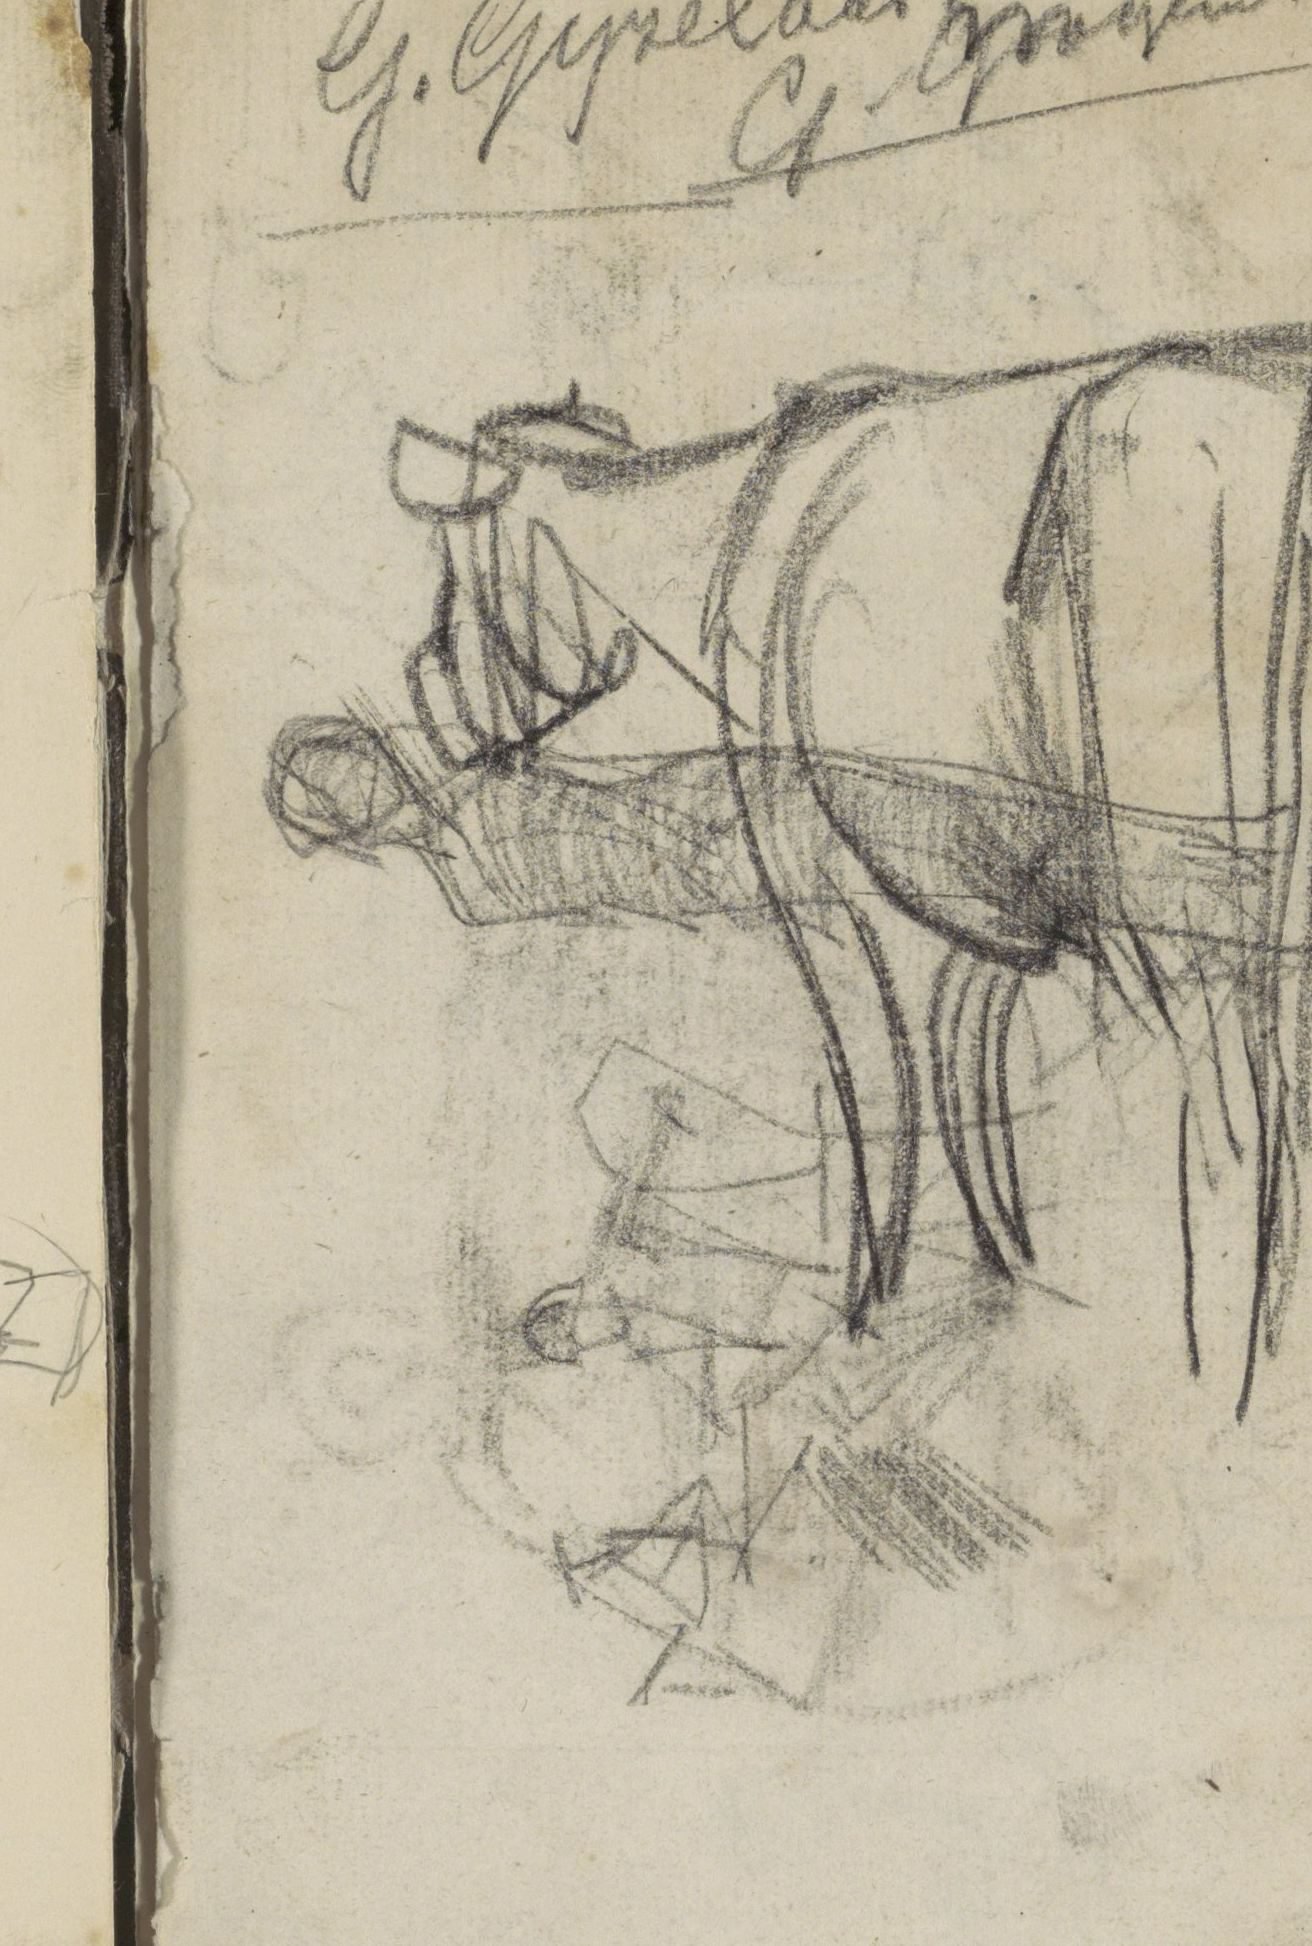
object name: sketchbook leaf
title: Figuurstudies en een koe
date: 1880-1882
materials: chalk, paper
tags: standing figure, cow, adult man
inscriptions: annotation: ‘G. Gijzelaar/ [...]’, workshop stamp: Lugt 291d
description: Pagina E, los aangetroffen tussen blad 33 en het achterste schutblad in een schetsboek met 16 bladen.